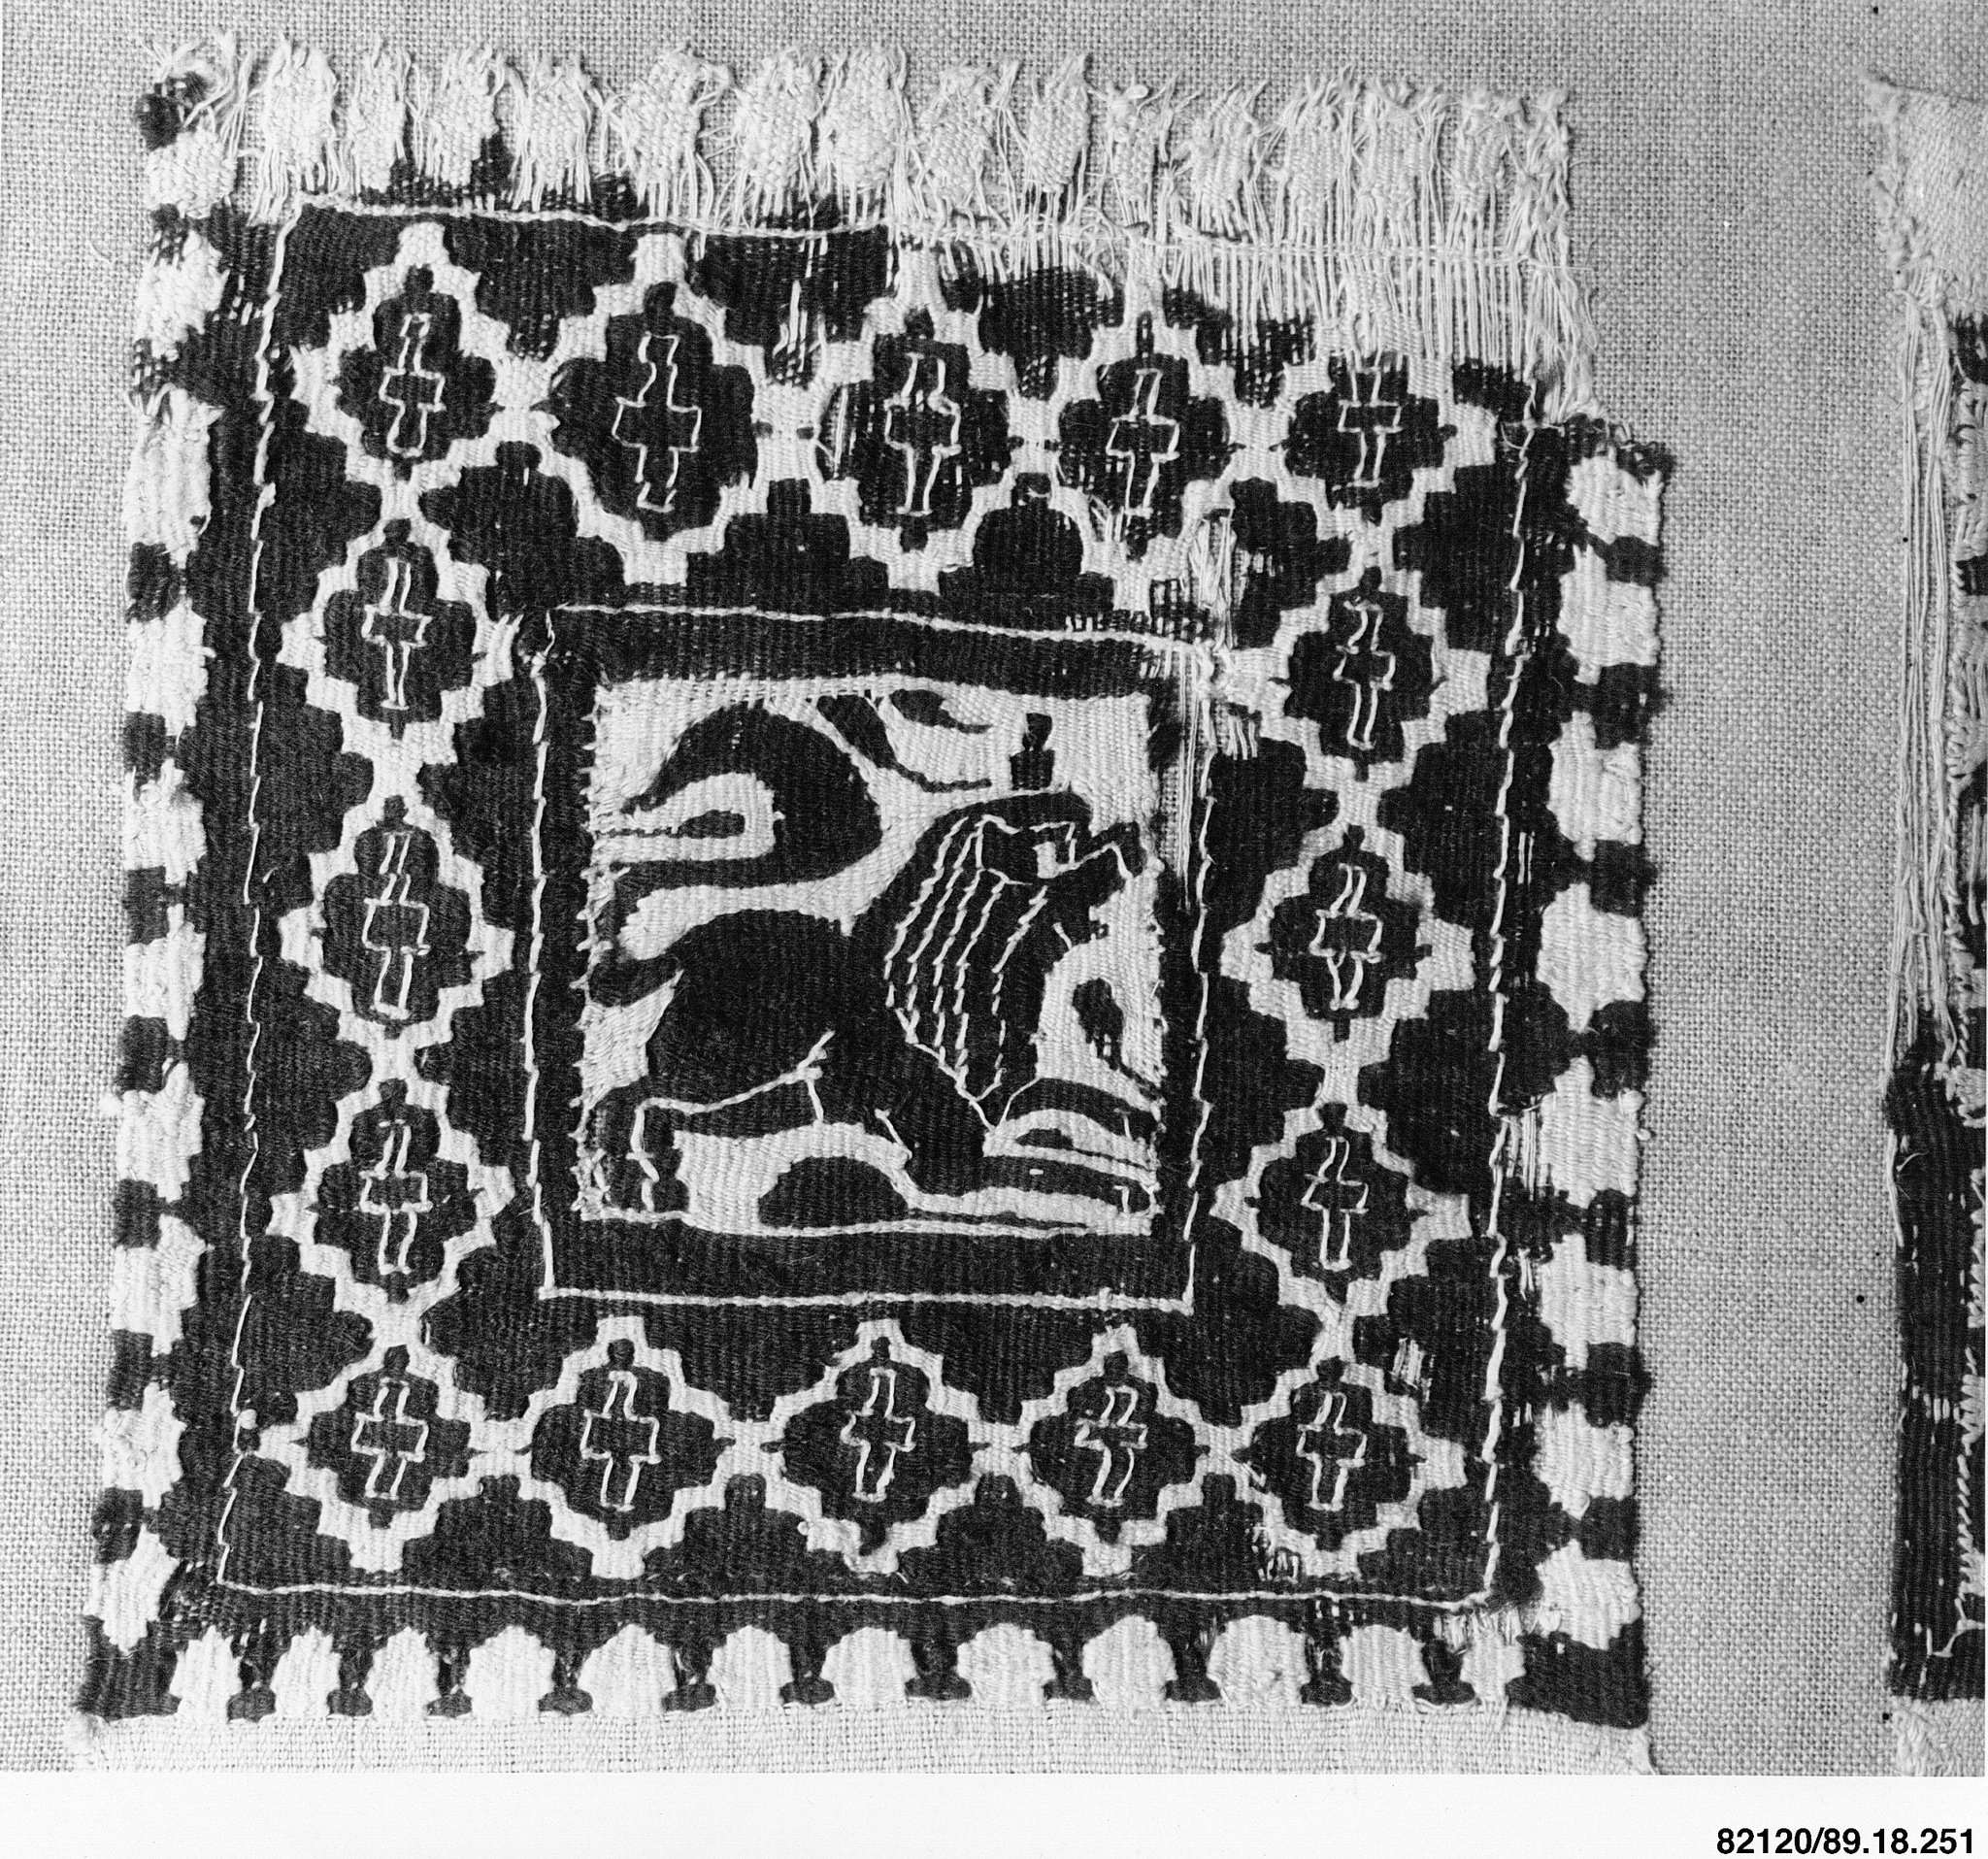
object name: textile fragment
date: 301-400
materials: linen, wool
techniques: weave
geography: egypt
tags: animals